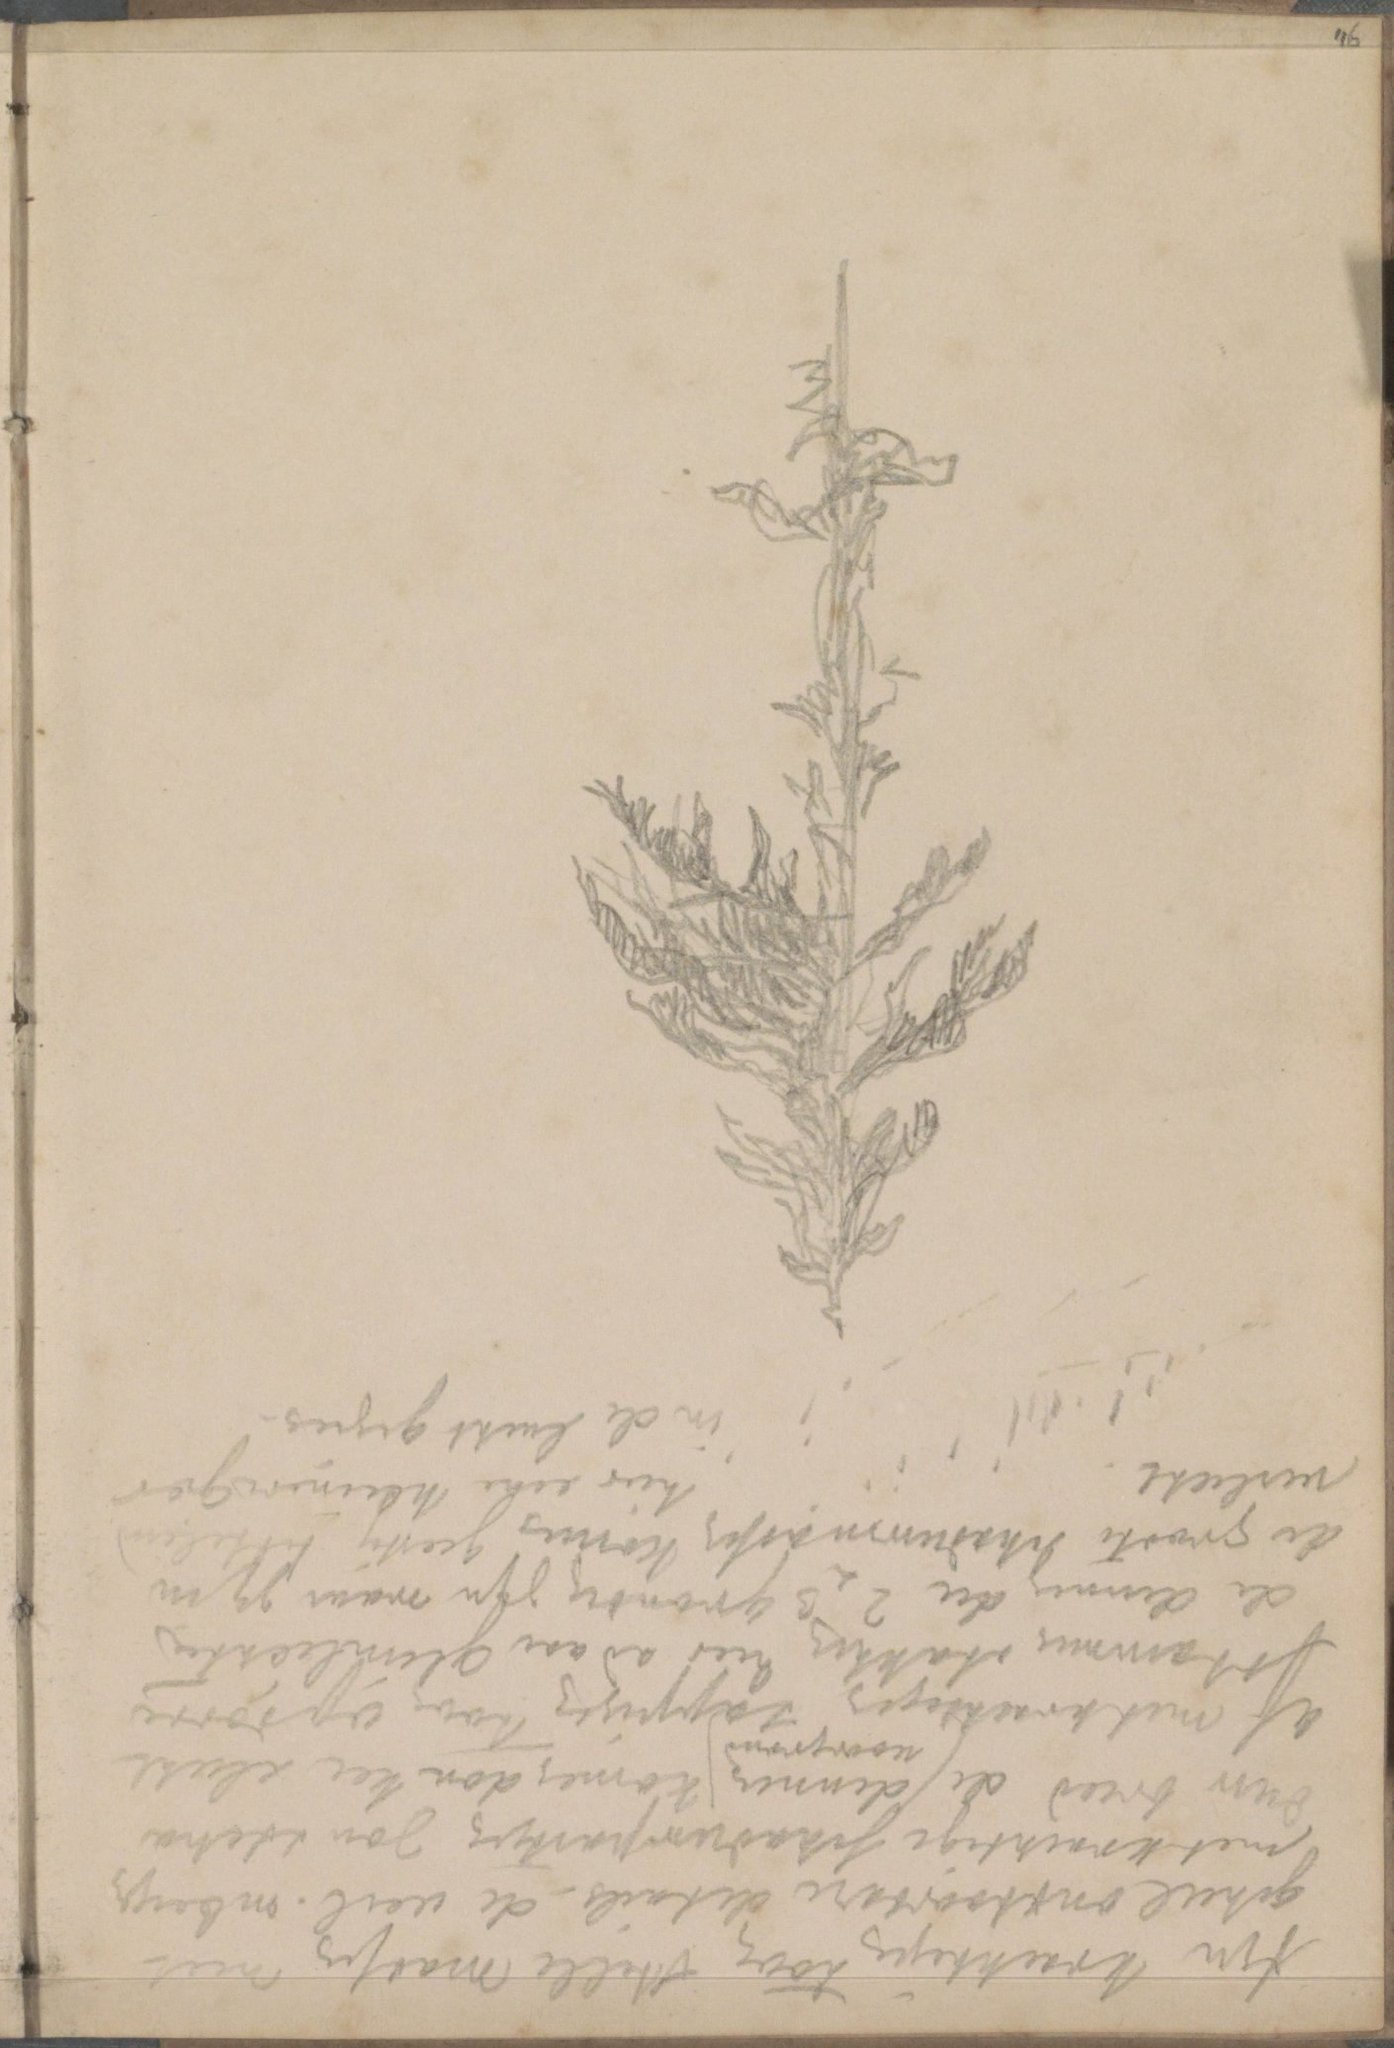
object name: sketchbook leaf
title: Dennenboom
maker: johannes tavenraat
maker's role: draughtsman, painter, print maker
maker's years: 1809-1881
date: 1809-1858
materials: paper, pencil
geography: krimml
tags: trees: pine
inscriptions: annotation: ‘[...]’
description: Blad 46 recto uit een schetsboek met 47 bladen.